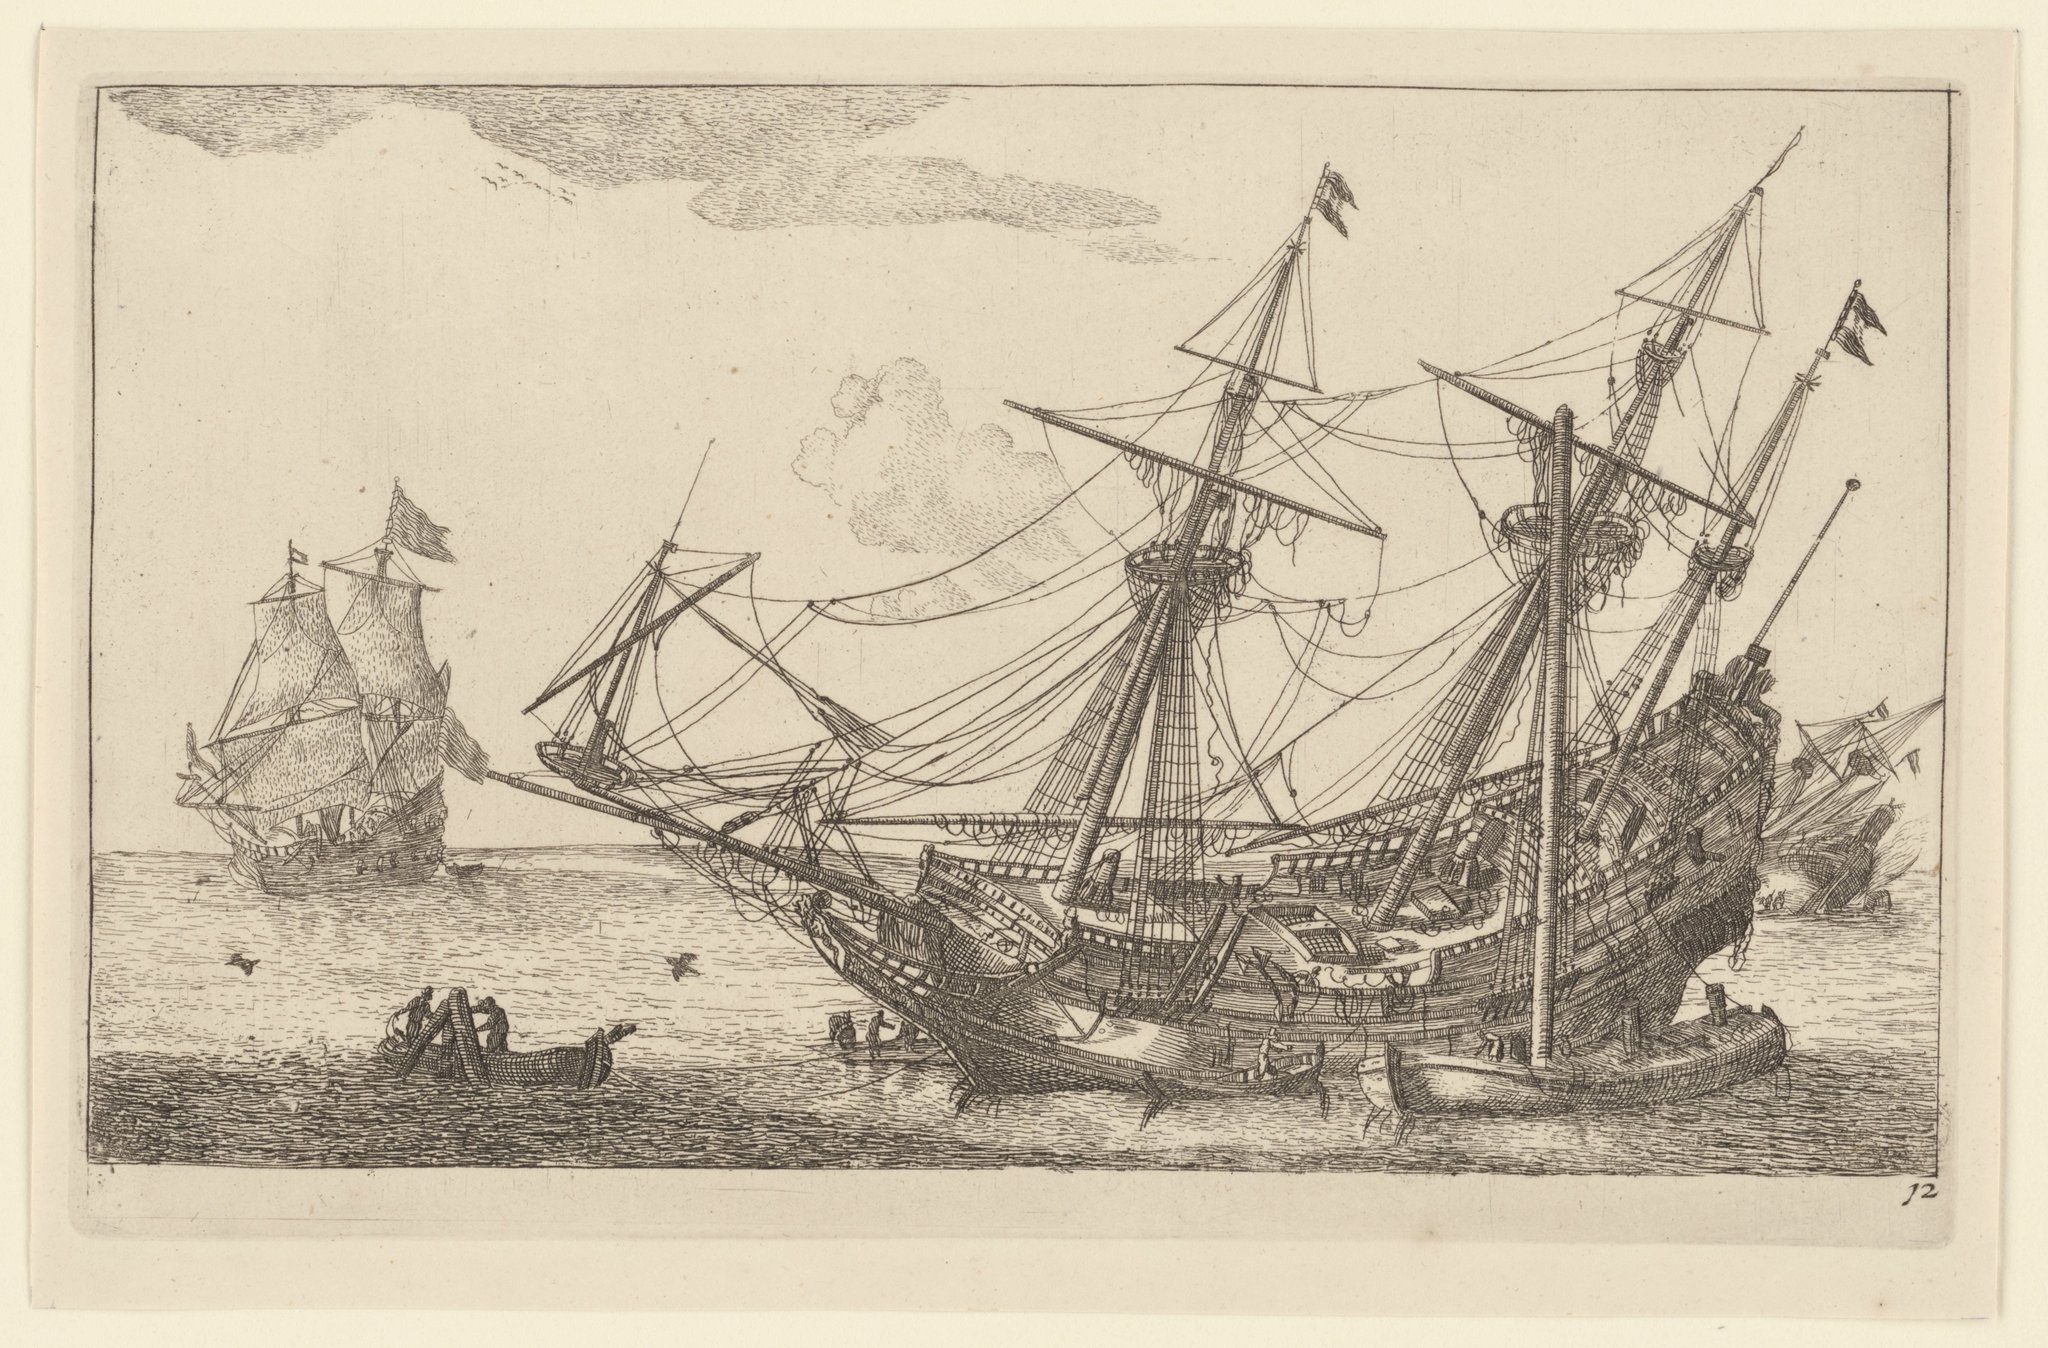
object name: print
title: Reparaties aan de romp van een koopvaardijschip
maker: Anonymous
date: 1652-1714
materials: paper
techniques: etching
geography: netherlands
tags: repairing, caulking, careening (~ ship), sailing-ship, sailing-boat (with name)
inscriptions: collector's mark: Lugt 2228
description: Kopie in spiegelbeeld. Een onderlegger trekt een groot koopvaardijschip scheef, drie mannen op een vlot zijn bezig de romp waterdicht te maken.